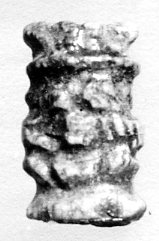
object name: amulet, be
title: Bes amulet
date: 664-332 BCE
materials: faience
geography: egypt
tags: bes